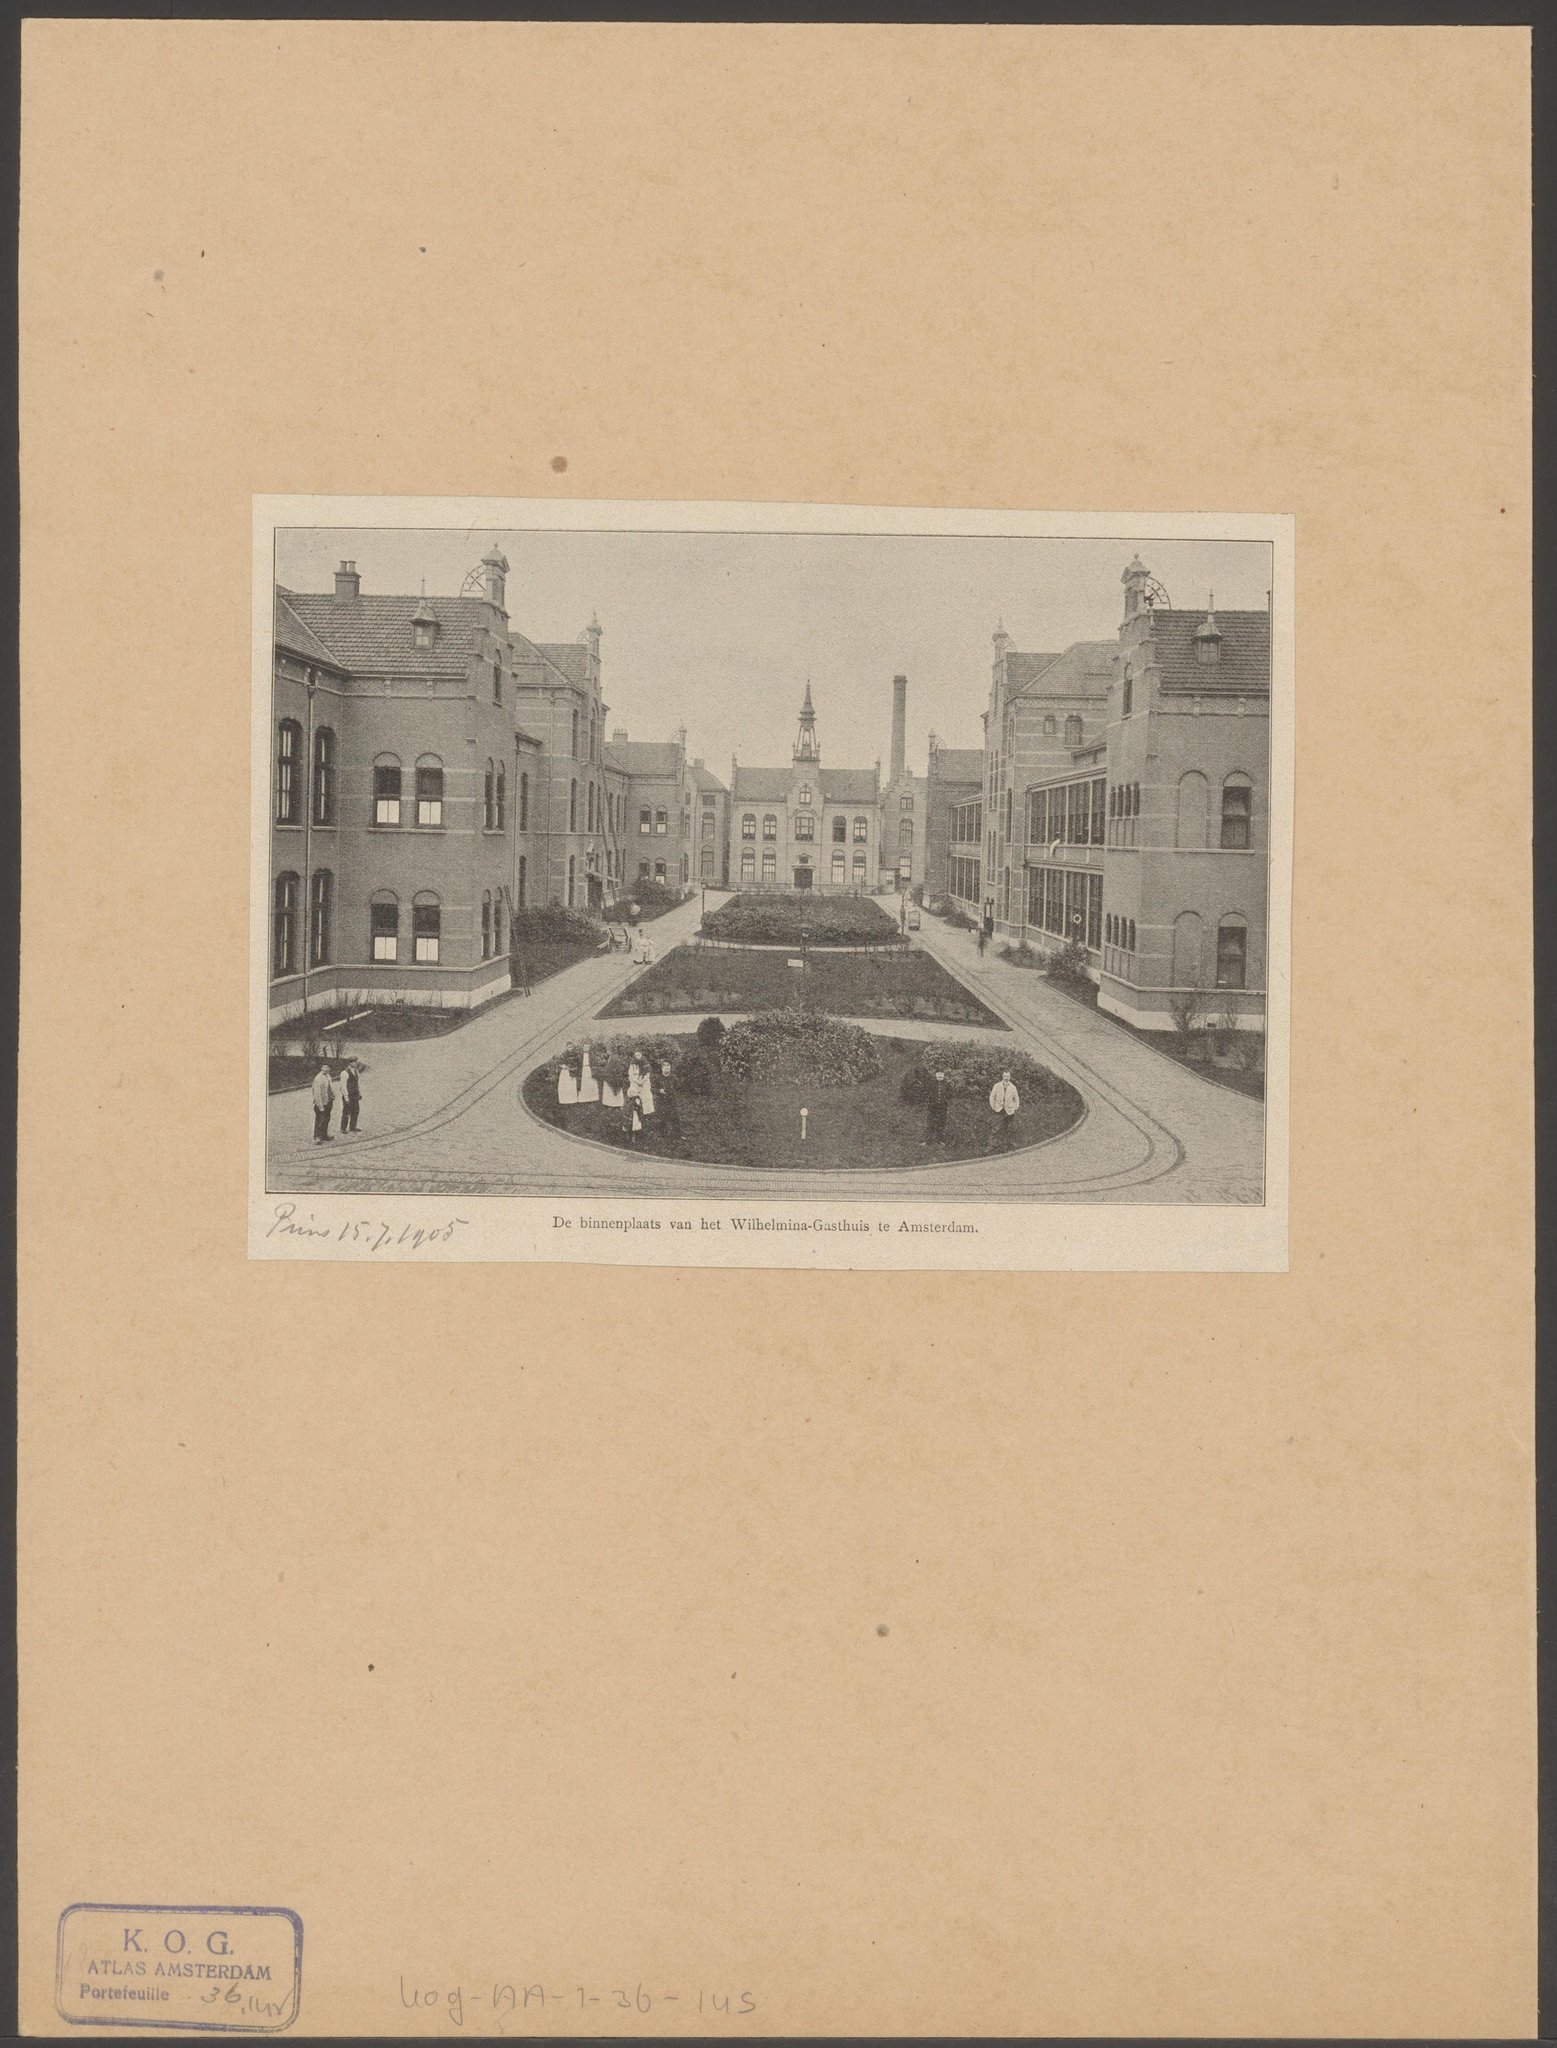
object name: photomechanical print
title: Binnenplaats van het Wilhelmina Gasthuis te Amsterdam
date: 1905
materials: paper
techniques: letterpress printing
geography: amsterdam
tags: nurse ~ hospital, courtyard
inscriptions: collector's mark: Lugt 1641b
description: Binnenplaats van het Wilhelmina Gasthuis te Amsterdam. Onderwerpsrubriek binnen de Atlas Amsterdam: Armwezen en liefdadige instellingen: I. Stadsinrichtingen: Wilhelminagasthuis.